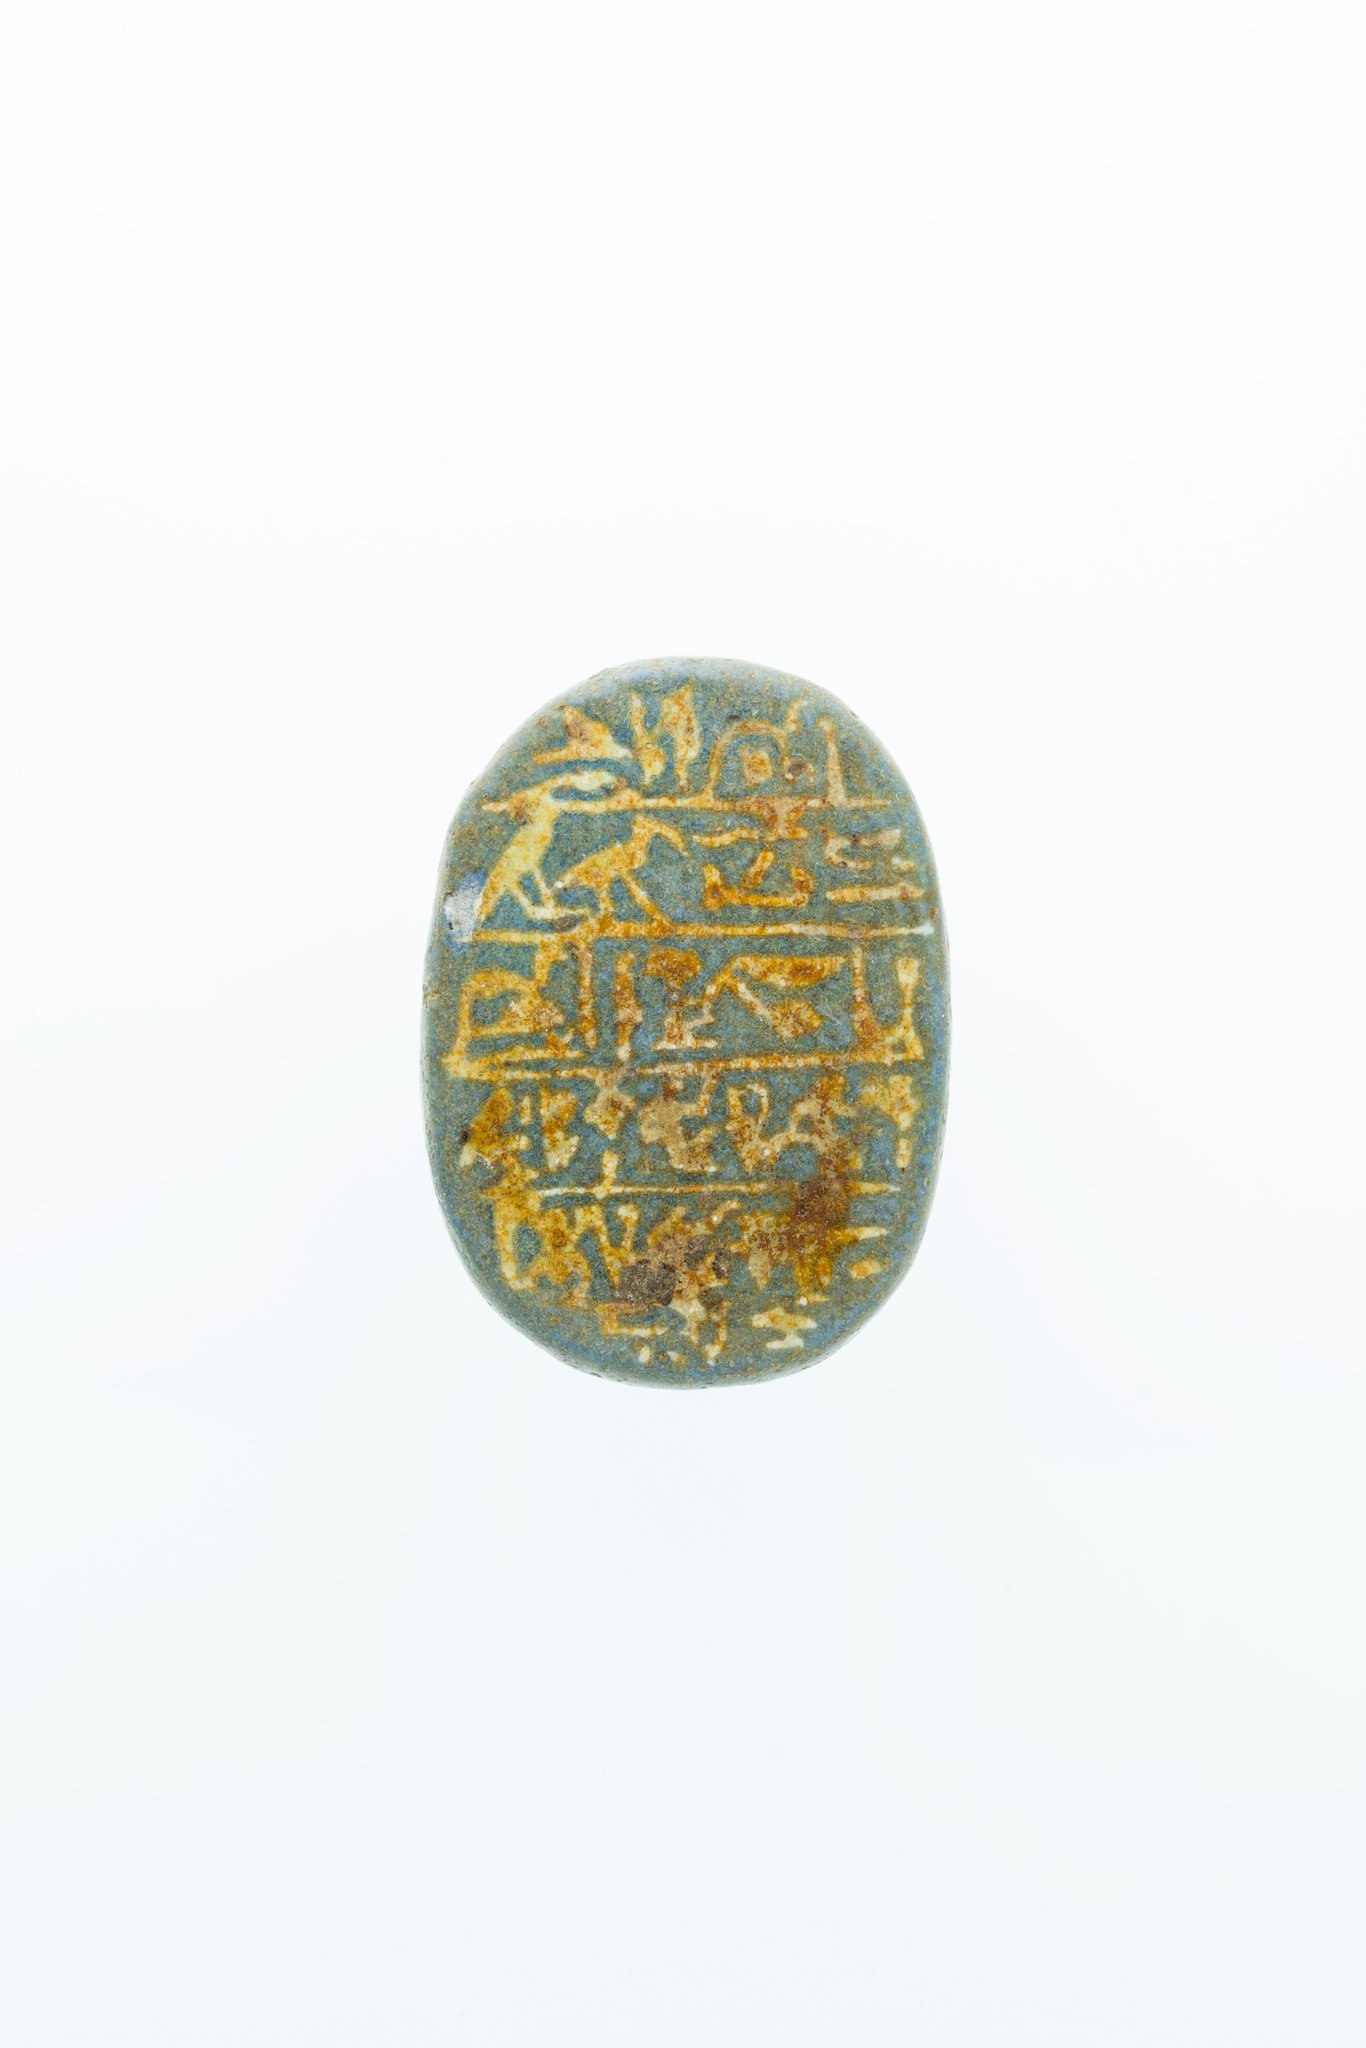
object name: heart scarab, djehutyemheb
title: Heart Scarab of Djehutyemheb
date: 1550-1186 BCE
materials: faience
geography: egypt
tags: hieroglyphs,scarabs